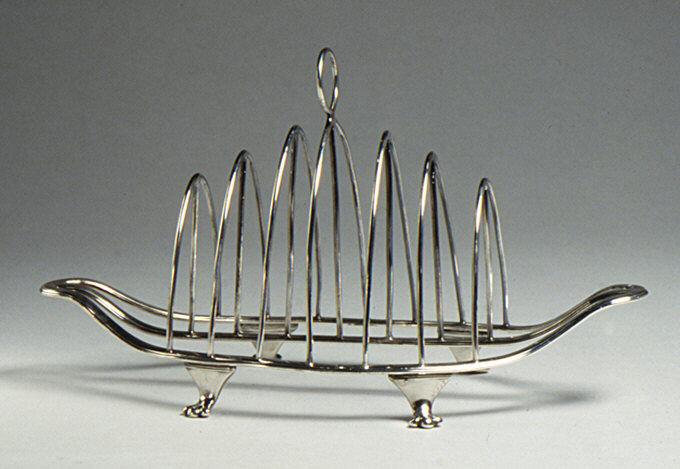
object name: toast rack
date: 1800-1801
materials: silver